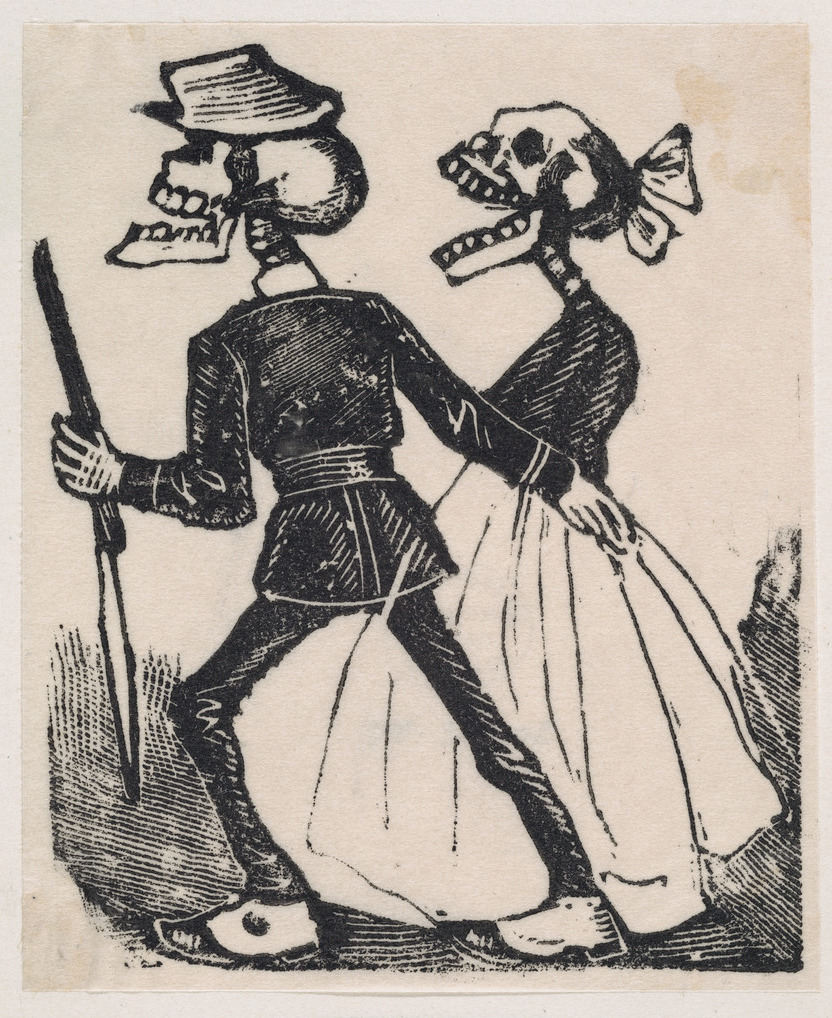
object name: print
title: A male skeleton leading a female skeleton to the left, from a broaside entitled 'La Calavera de Cupido', published by Antonio Vanegas Arroyo.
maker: josé guadalupe posada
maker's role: artist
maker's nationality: mexican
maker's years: 1852-1913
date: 1892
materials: metal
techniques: engraving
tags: skeletons